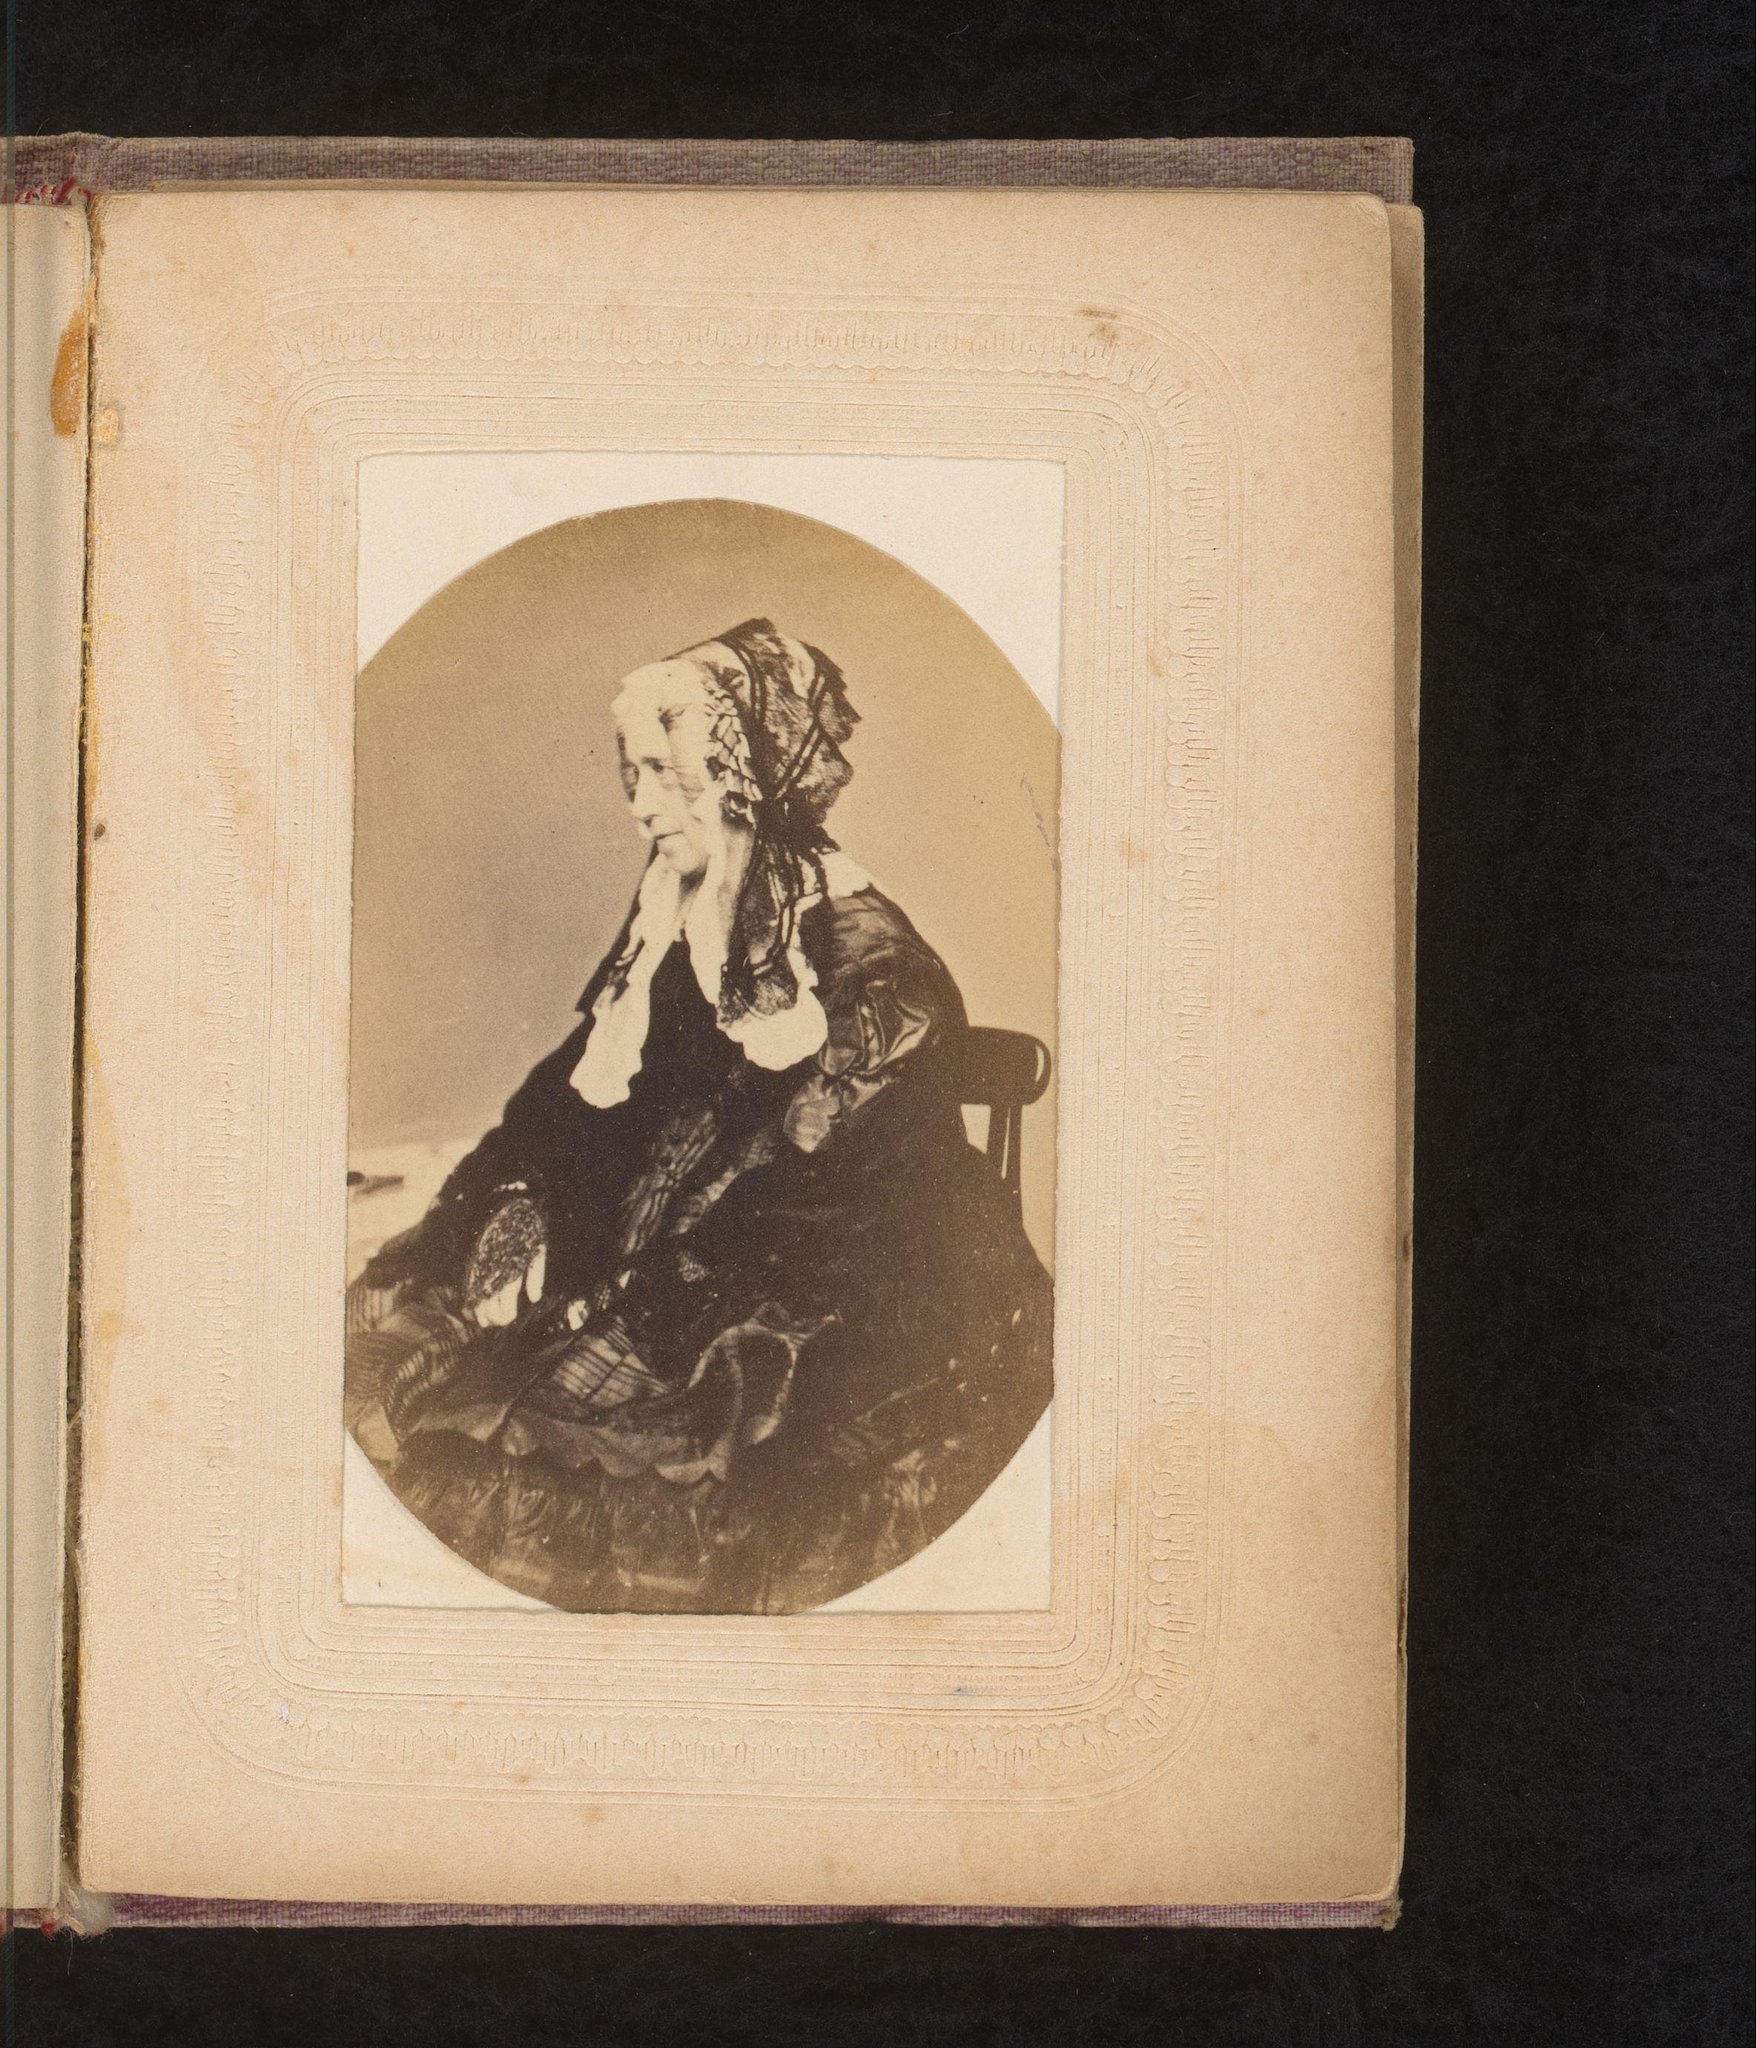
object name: carte de visite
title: Portret van een zittende vrouw in zwart met kanten muts, en profil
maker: Anonymous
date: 1860-1880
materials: cardboard, photographic support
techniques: albumen print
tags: sitting figure - aa - female human figure, historical persons - bb - woman, head-gear: cap